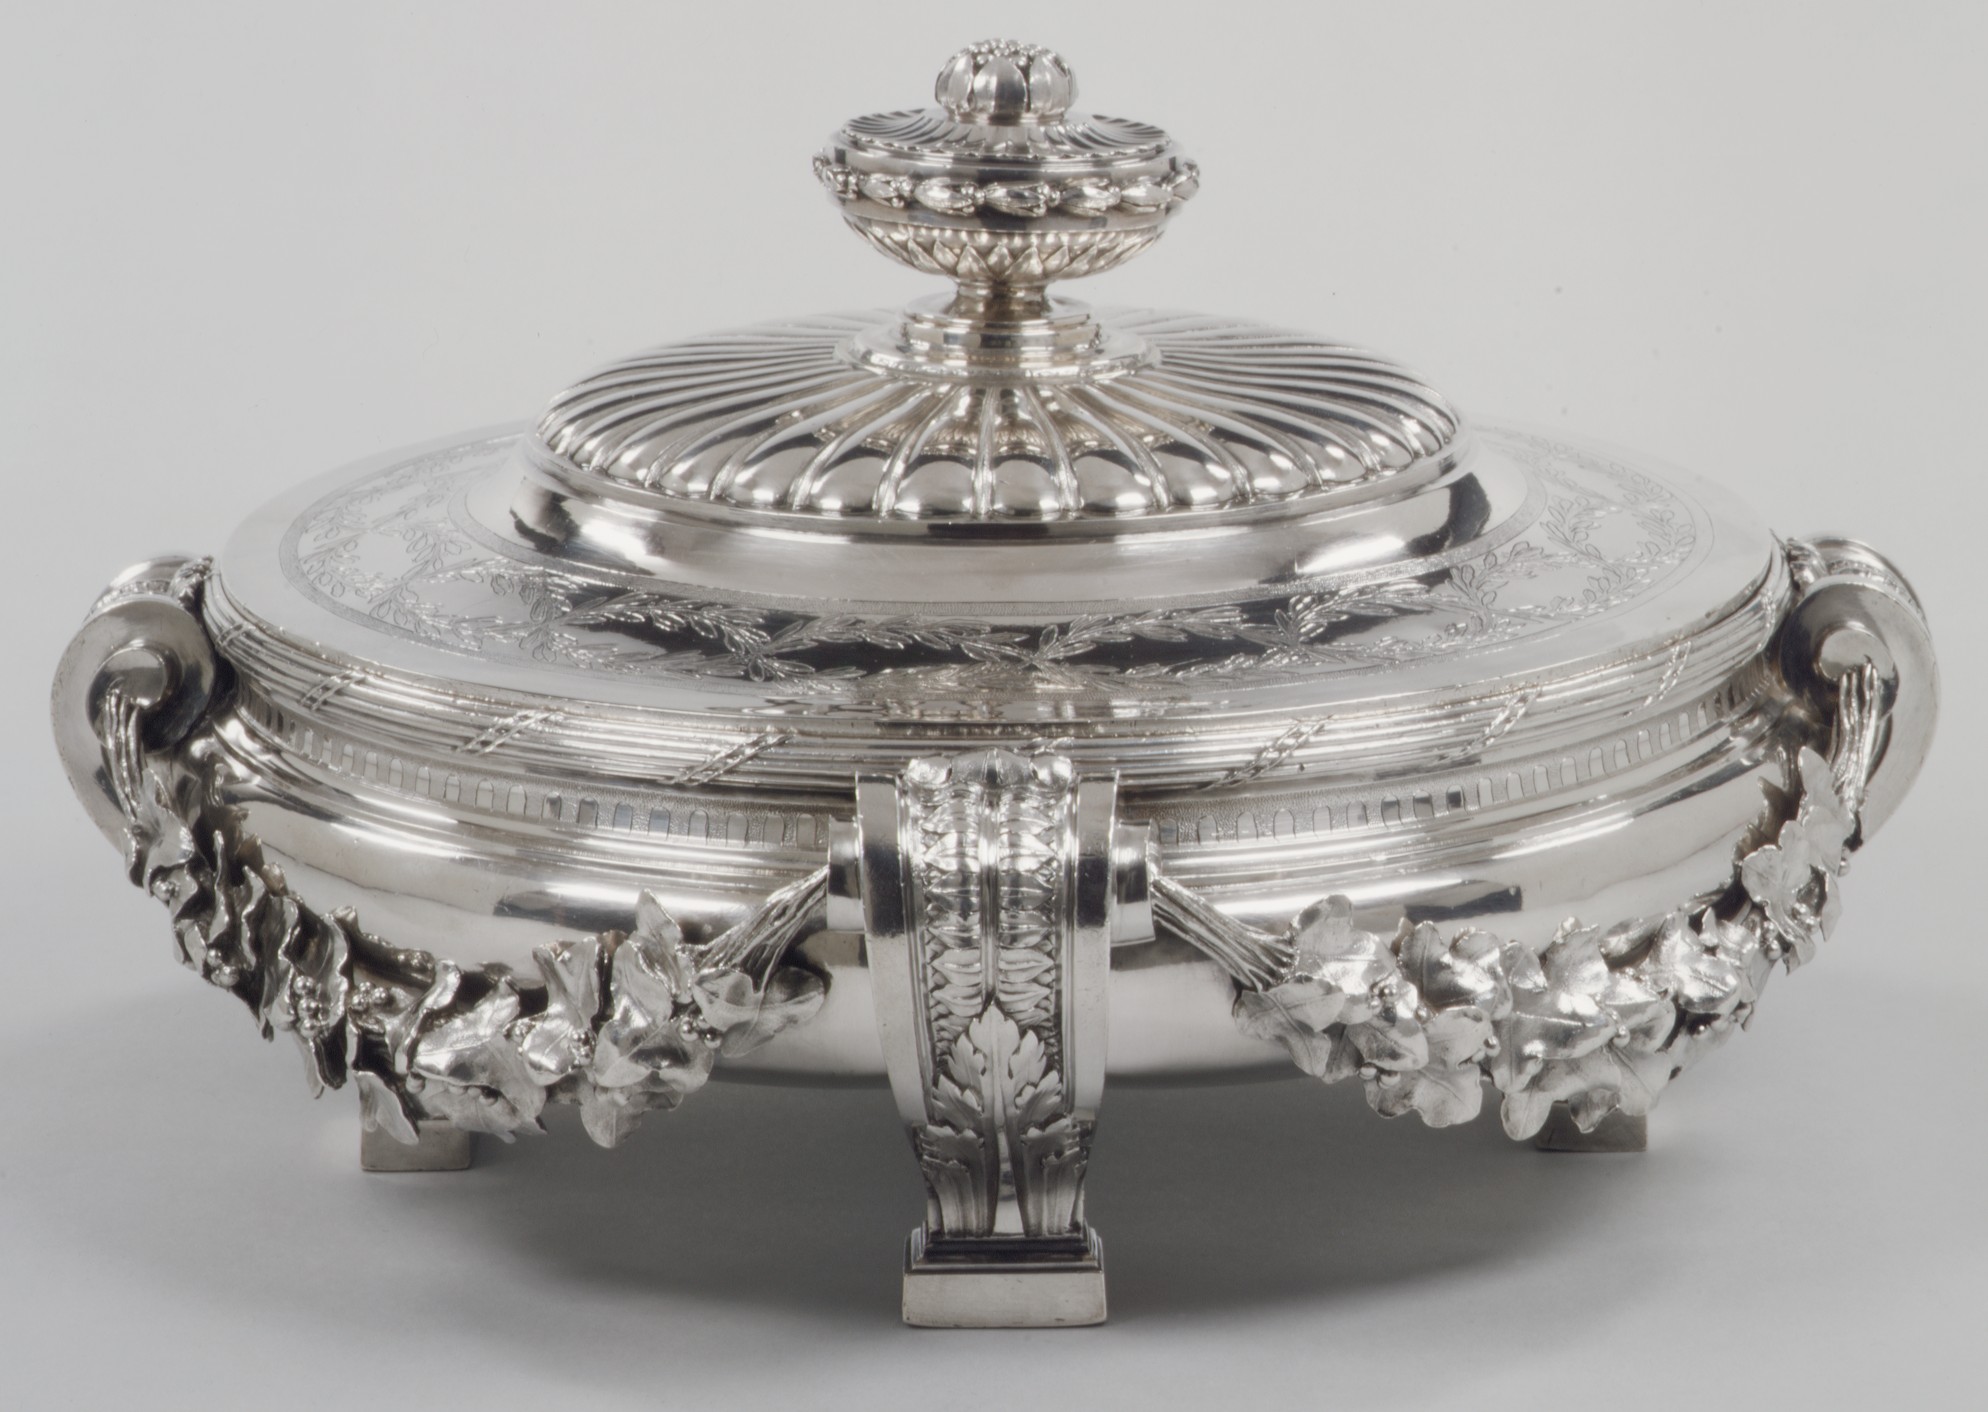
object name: dish with cover and liner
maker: jacques-nicolas roettiers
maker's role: maker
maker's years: 1736-1788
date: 1775-1776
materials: silver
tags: garlands